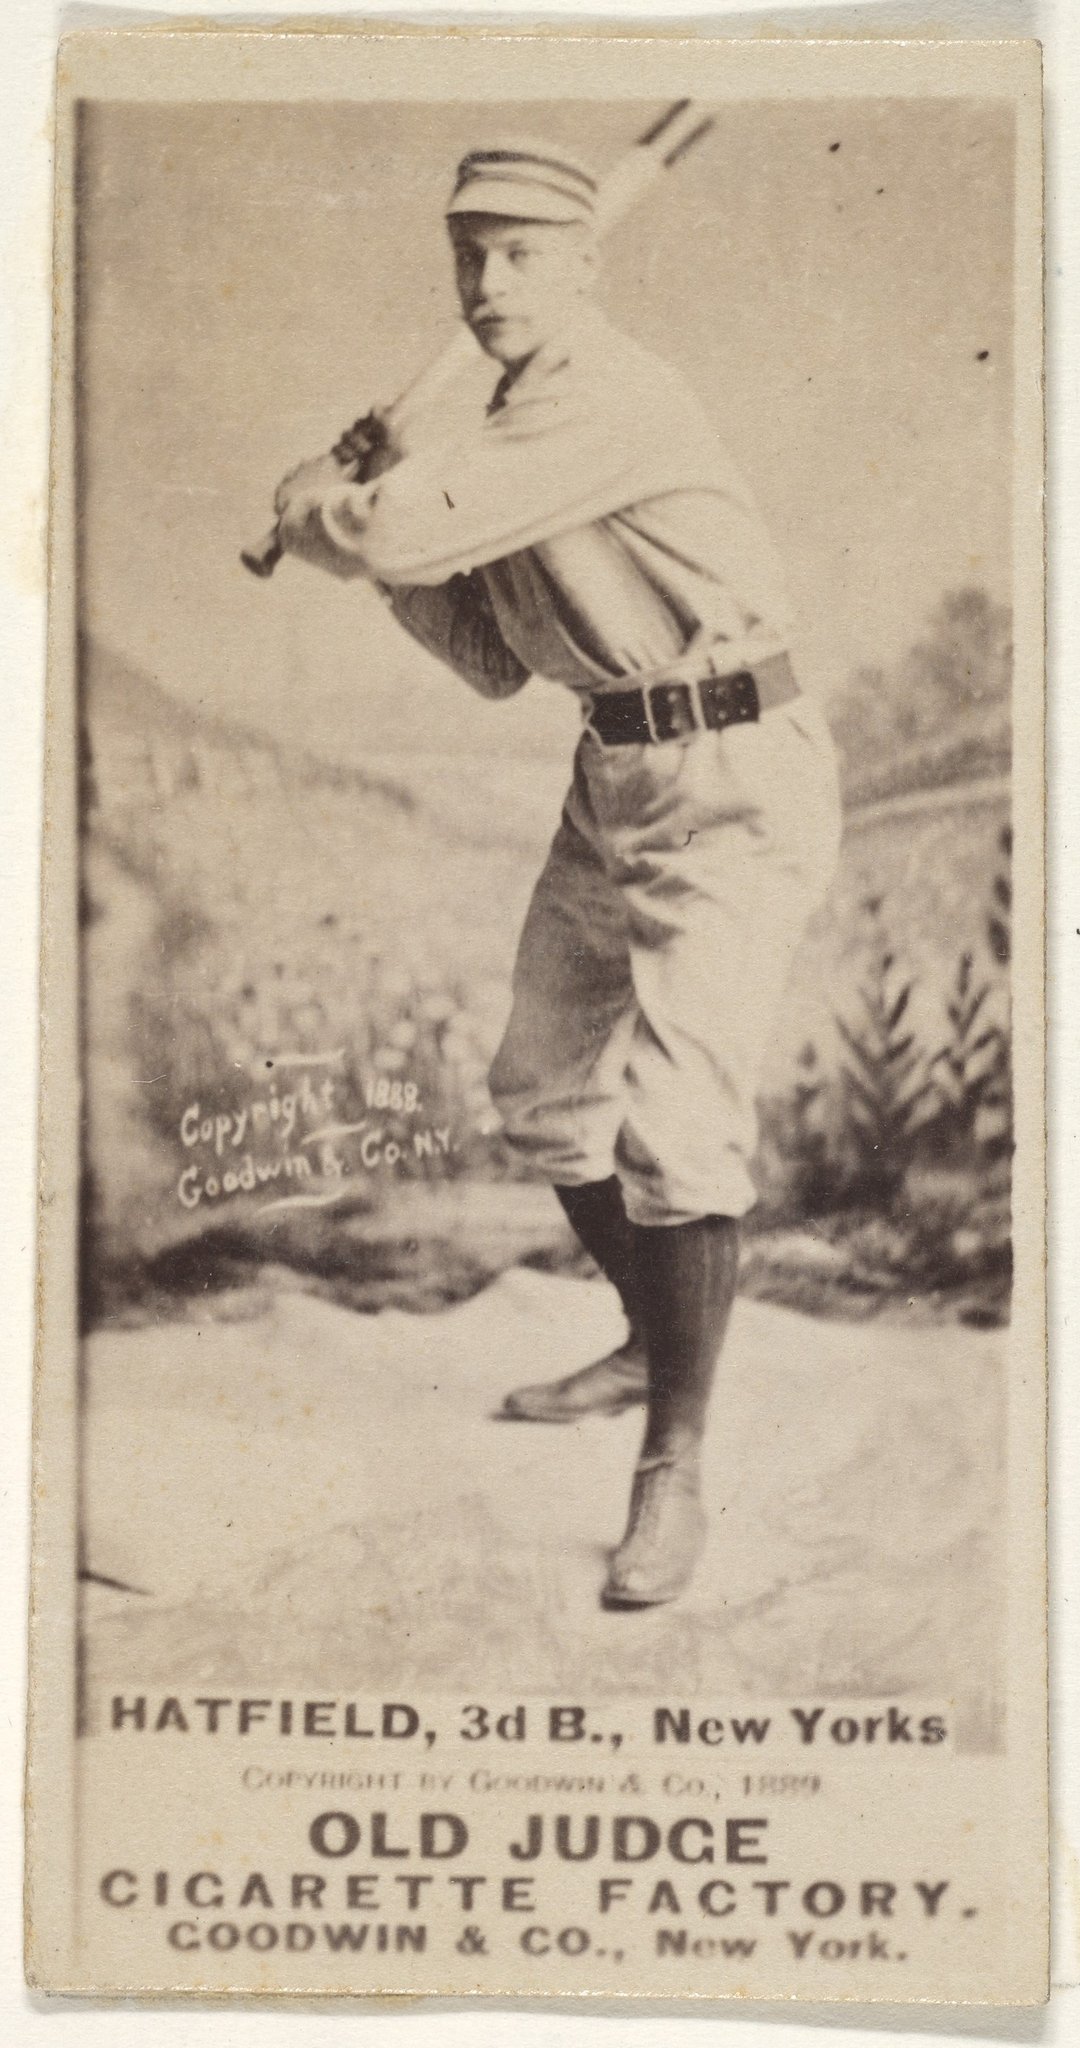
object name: baseball card, photograph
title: Gil Hatfield, 3rd Base, New York, from the Old Judge series (N172) for Old Judge Cigarettes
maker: goodwin & company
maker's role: publisher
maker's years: 1850-1950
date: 1889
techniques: albumen silver print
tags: men,portraits,baseball,athletes